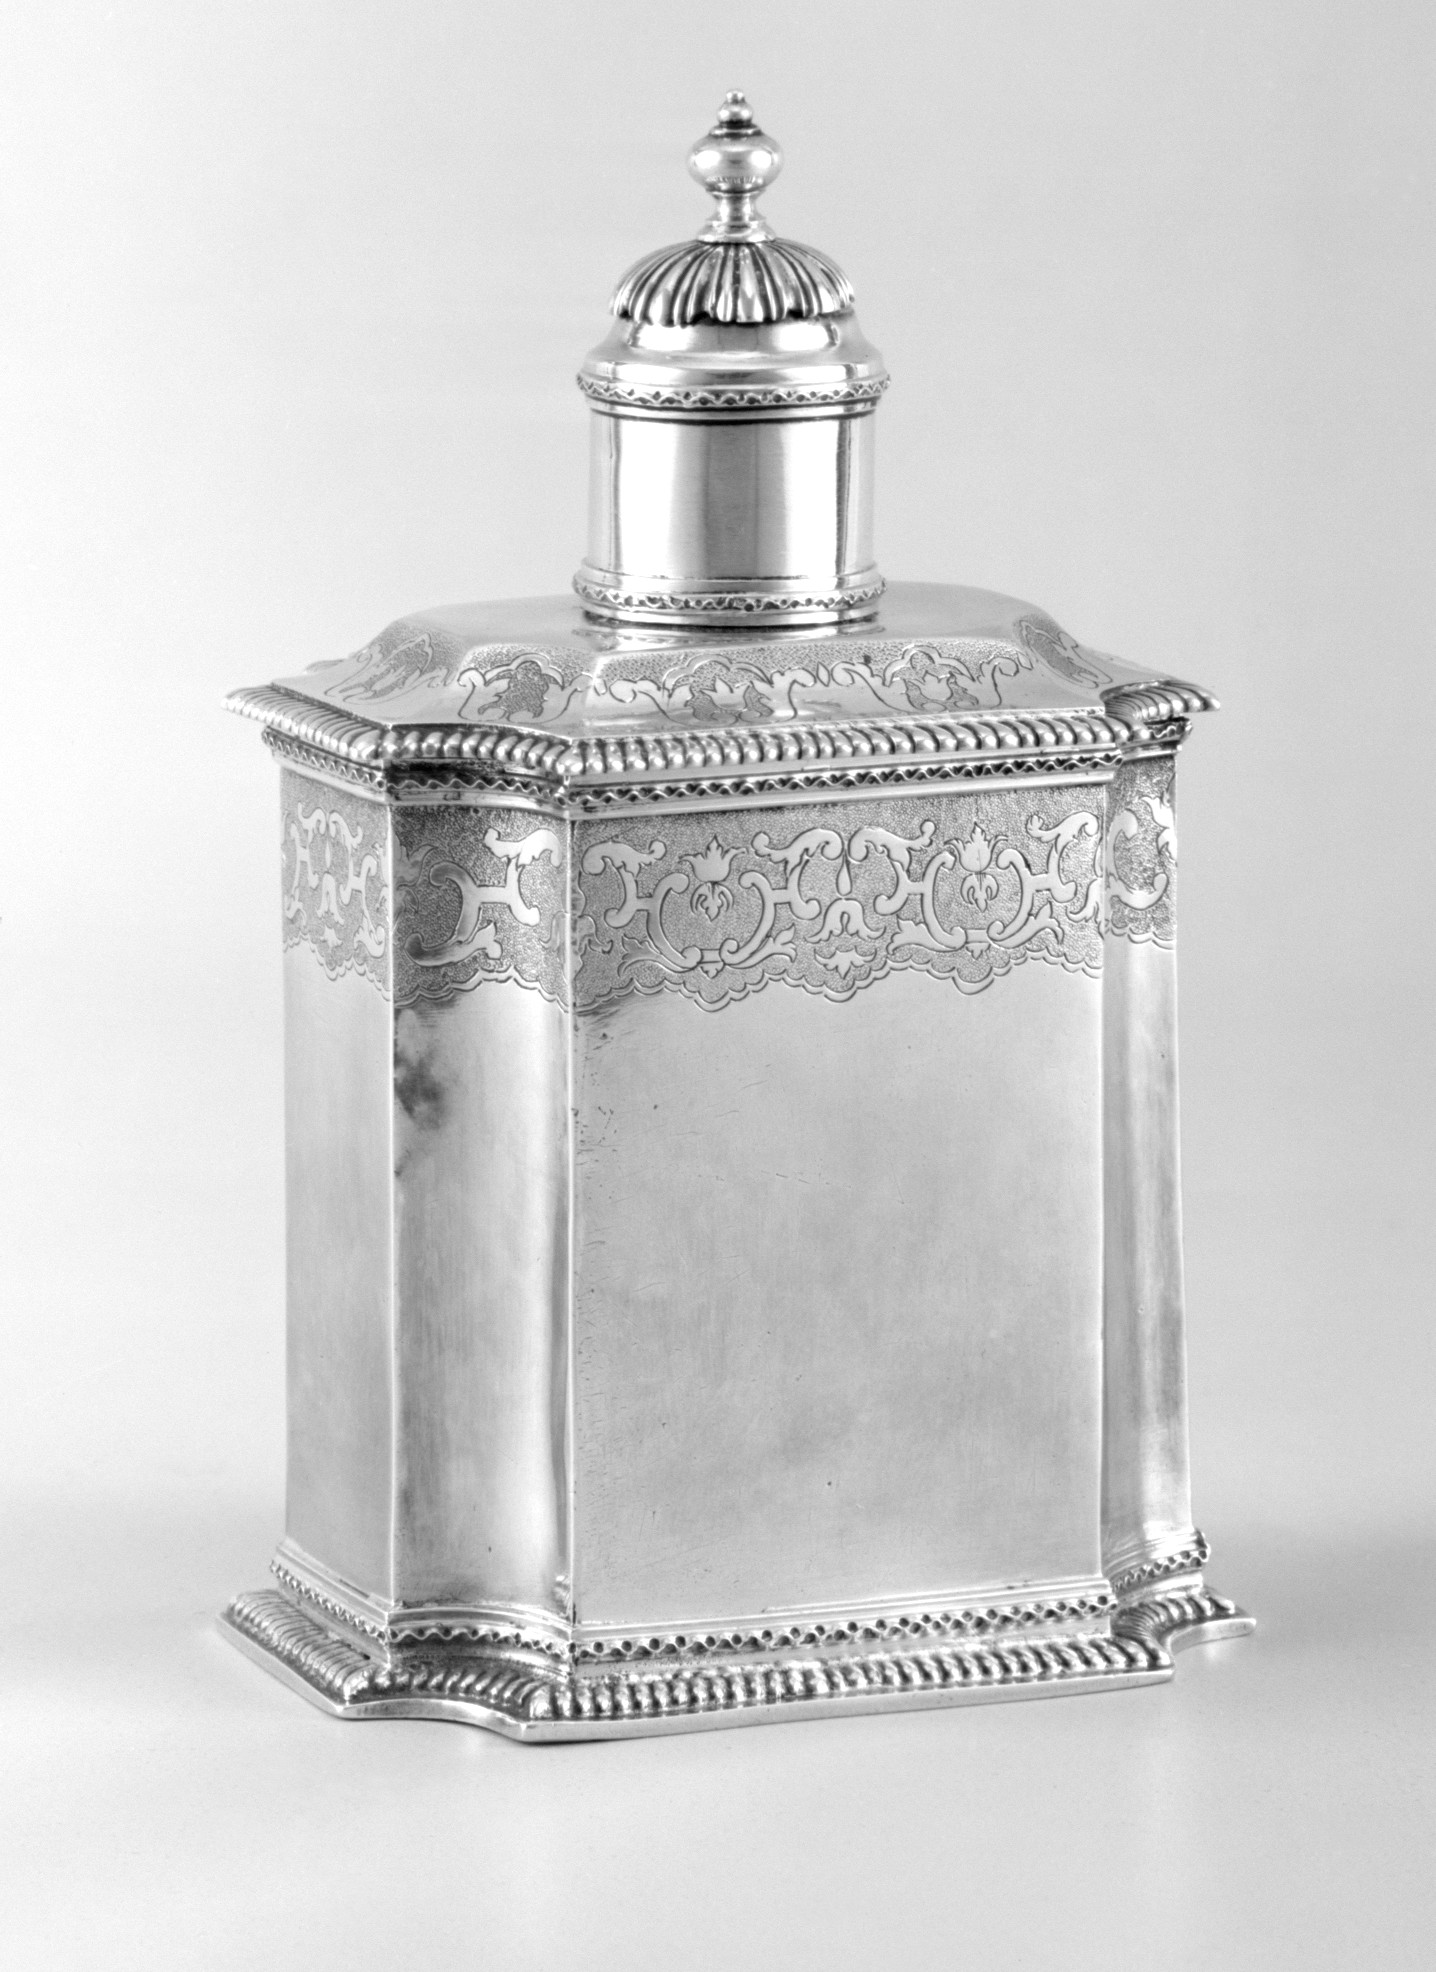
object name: tea caddy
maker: augustinus van der steene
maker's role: maker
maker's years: 1721-1731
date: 1739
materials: silver